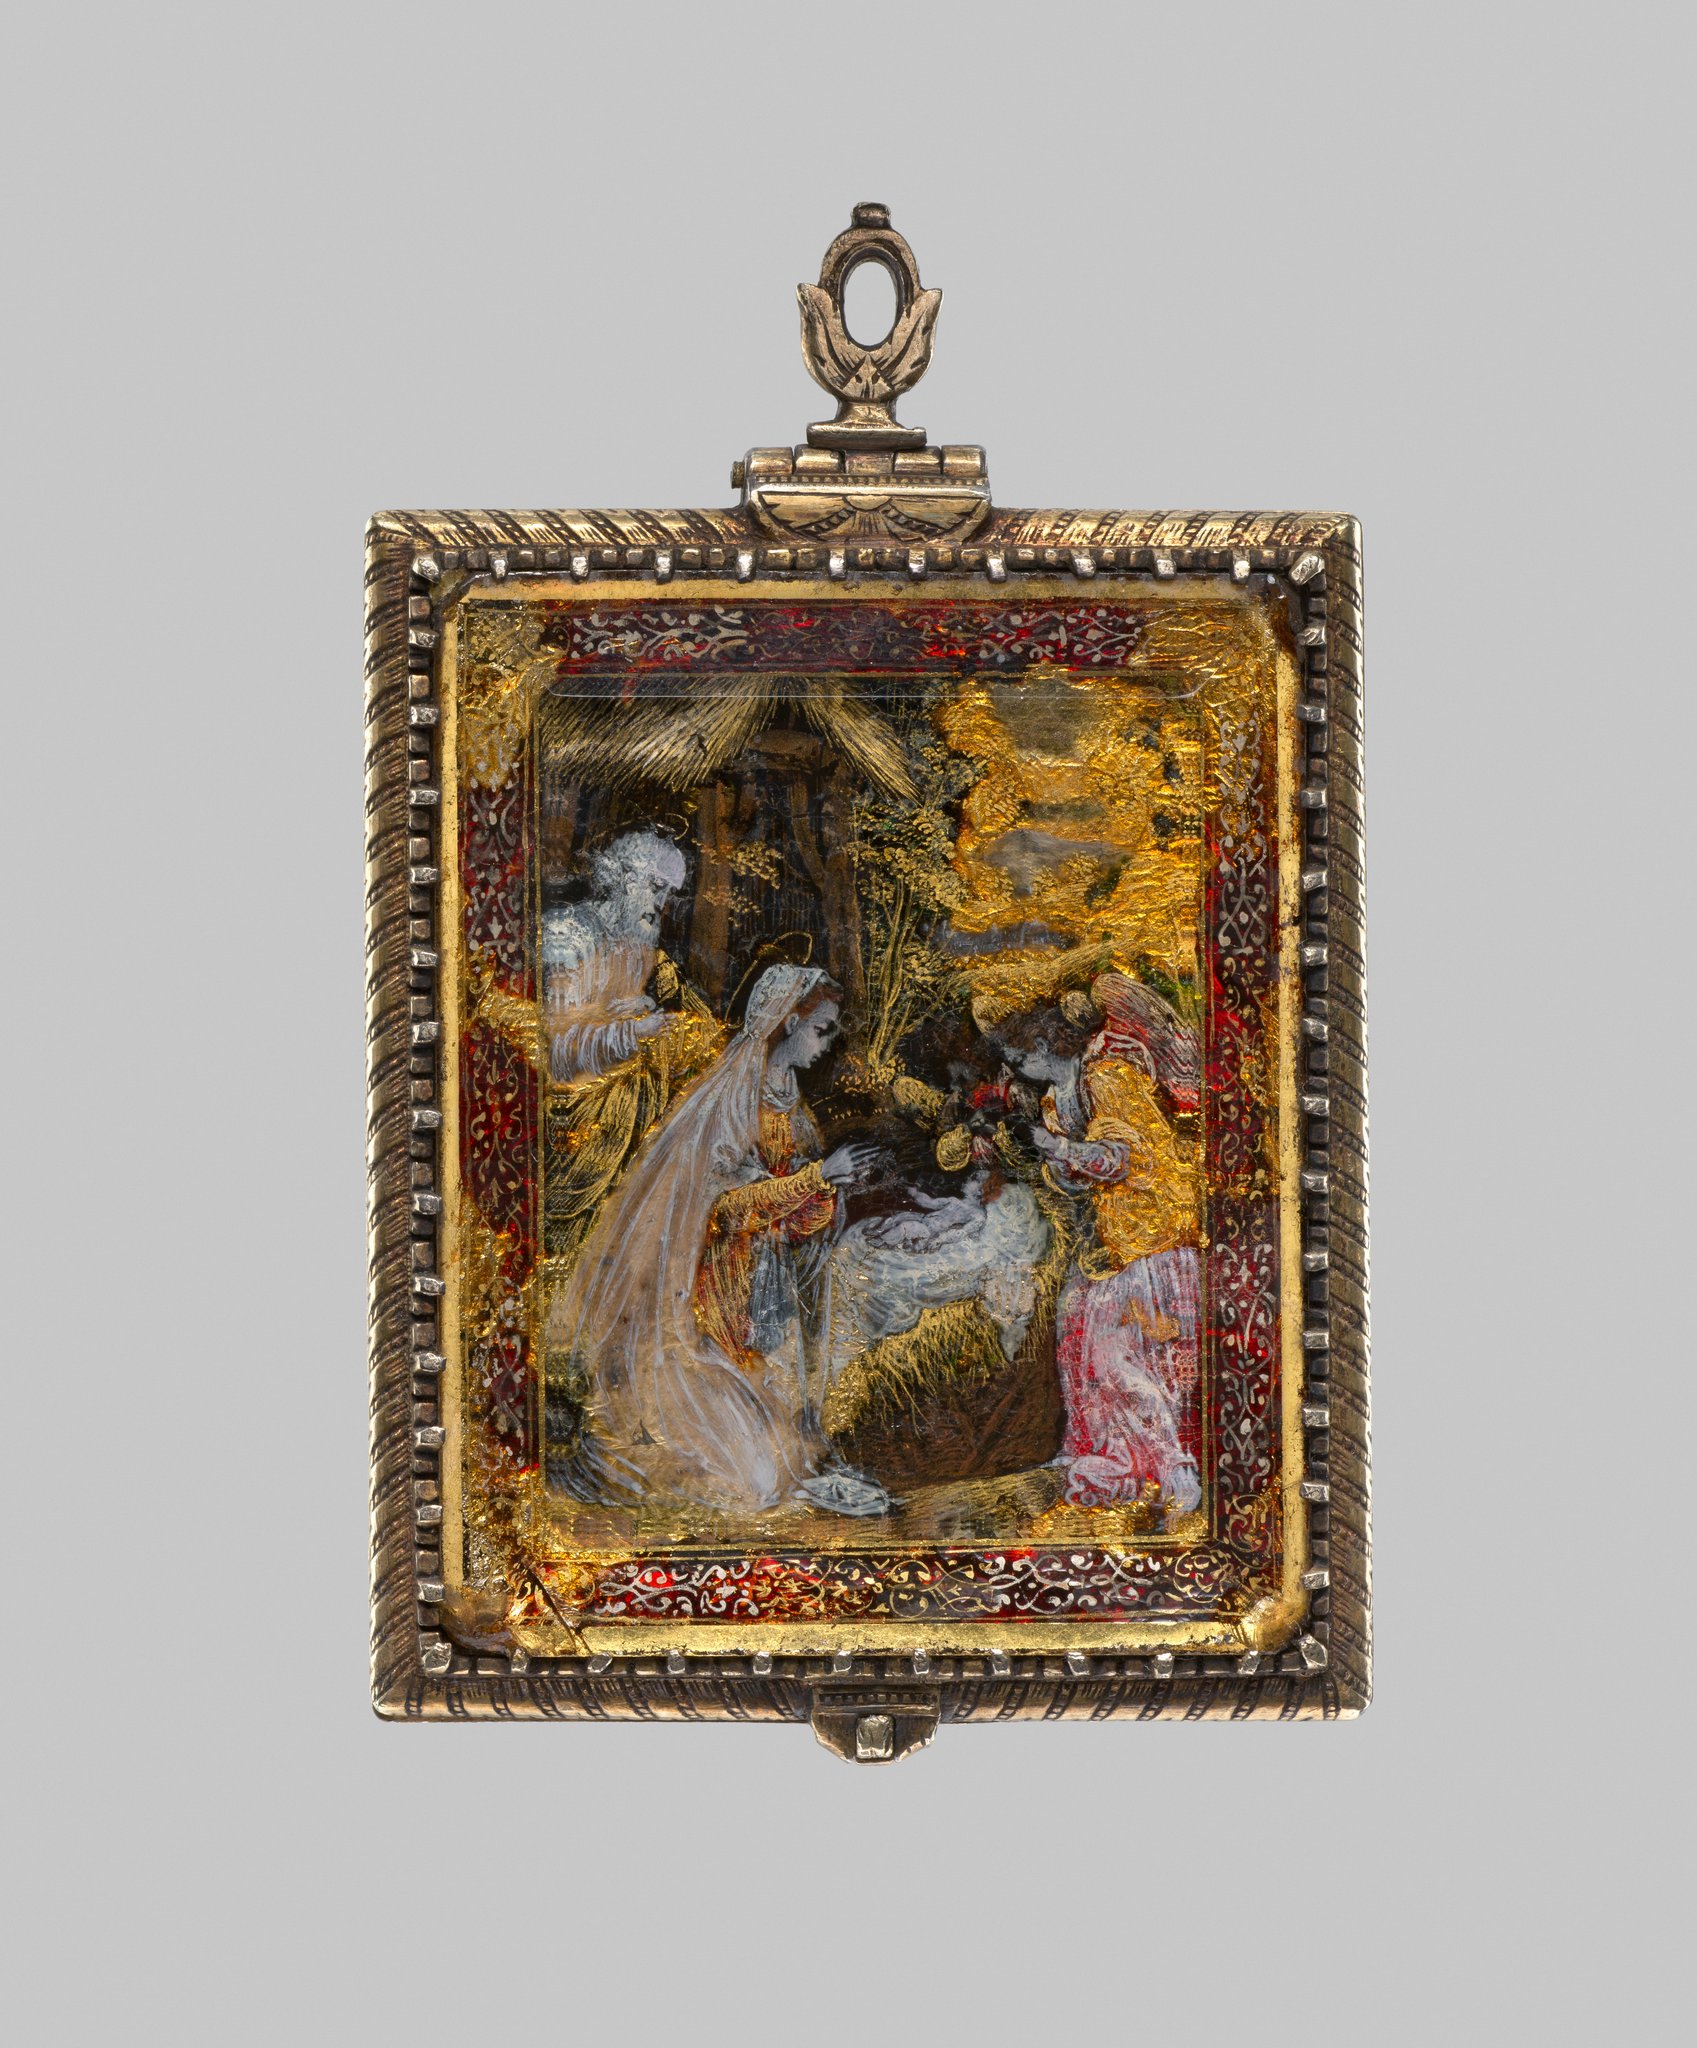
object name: pendant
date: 1501-1525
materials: gold, quartz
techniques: painting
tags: nativity